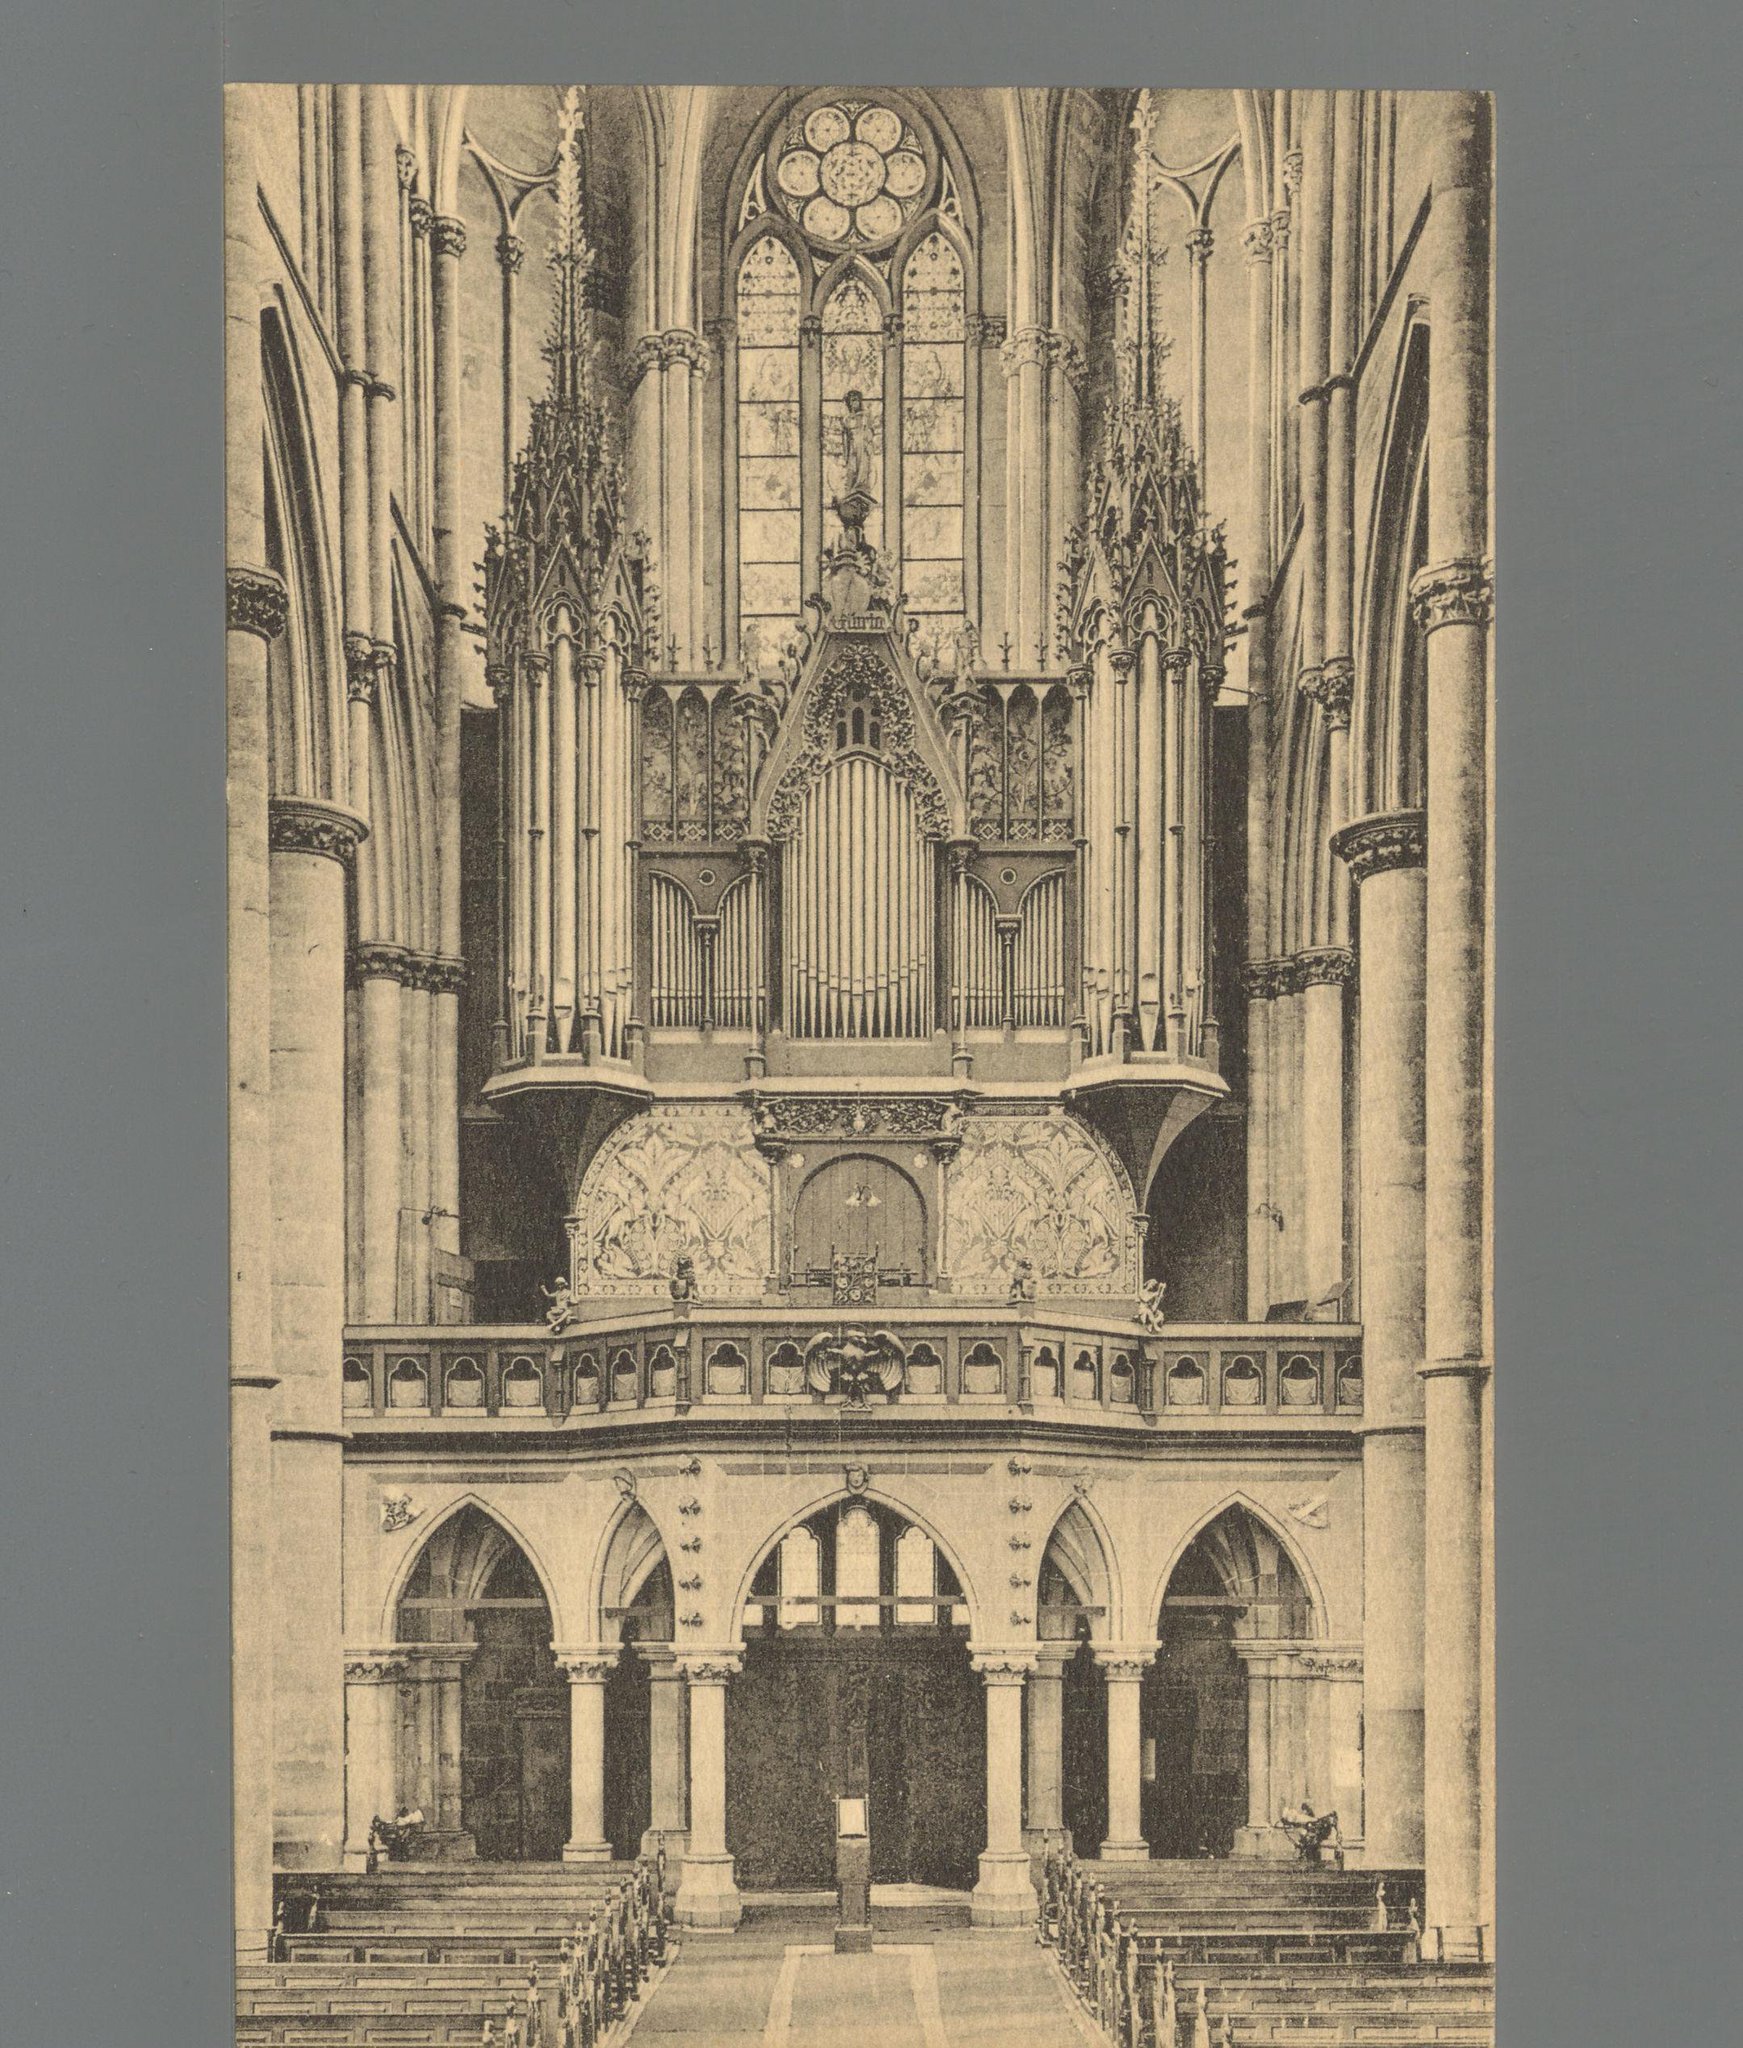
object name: photomechanical print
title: Trier. Liebfrauenkirche (13. Jahrh.)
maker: Anonymous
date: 1905-1930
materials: cardboard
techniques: photograph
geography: trier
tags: church organ, interior of church